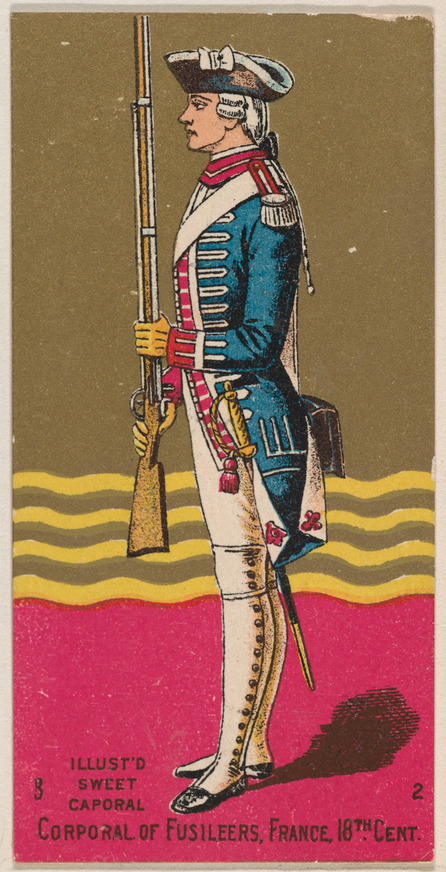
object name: print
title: Corporal of Fusileers, France, 18th Century, from the Military Series (N224) issued by Kinney Tobacco Company to promote Sweet Caporal Cigarettes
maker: kinney brothers tobacco company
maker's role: publisher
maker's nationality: american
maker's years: 1869-2011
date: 1888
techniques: color lithograph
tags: military,men,profiles